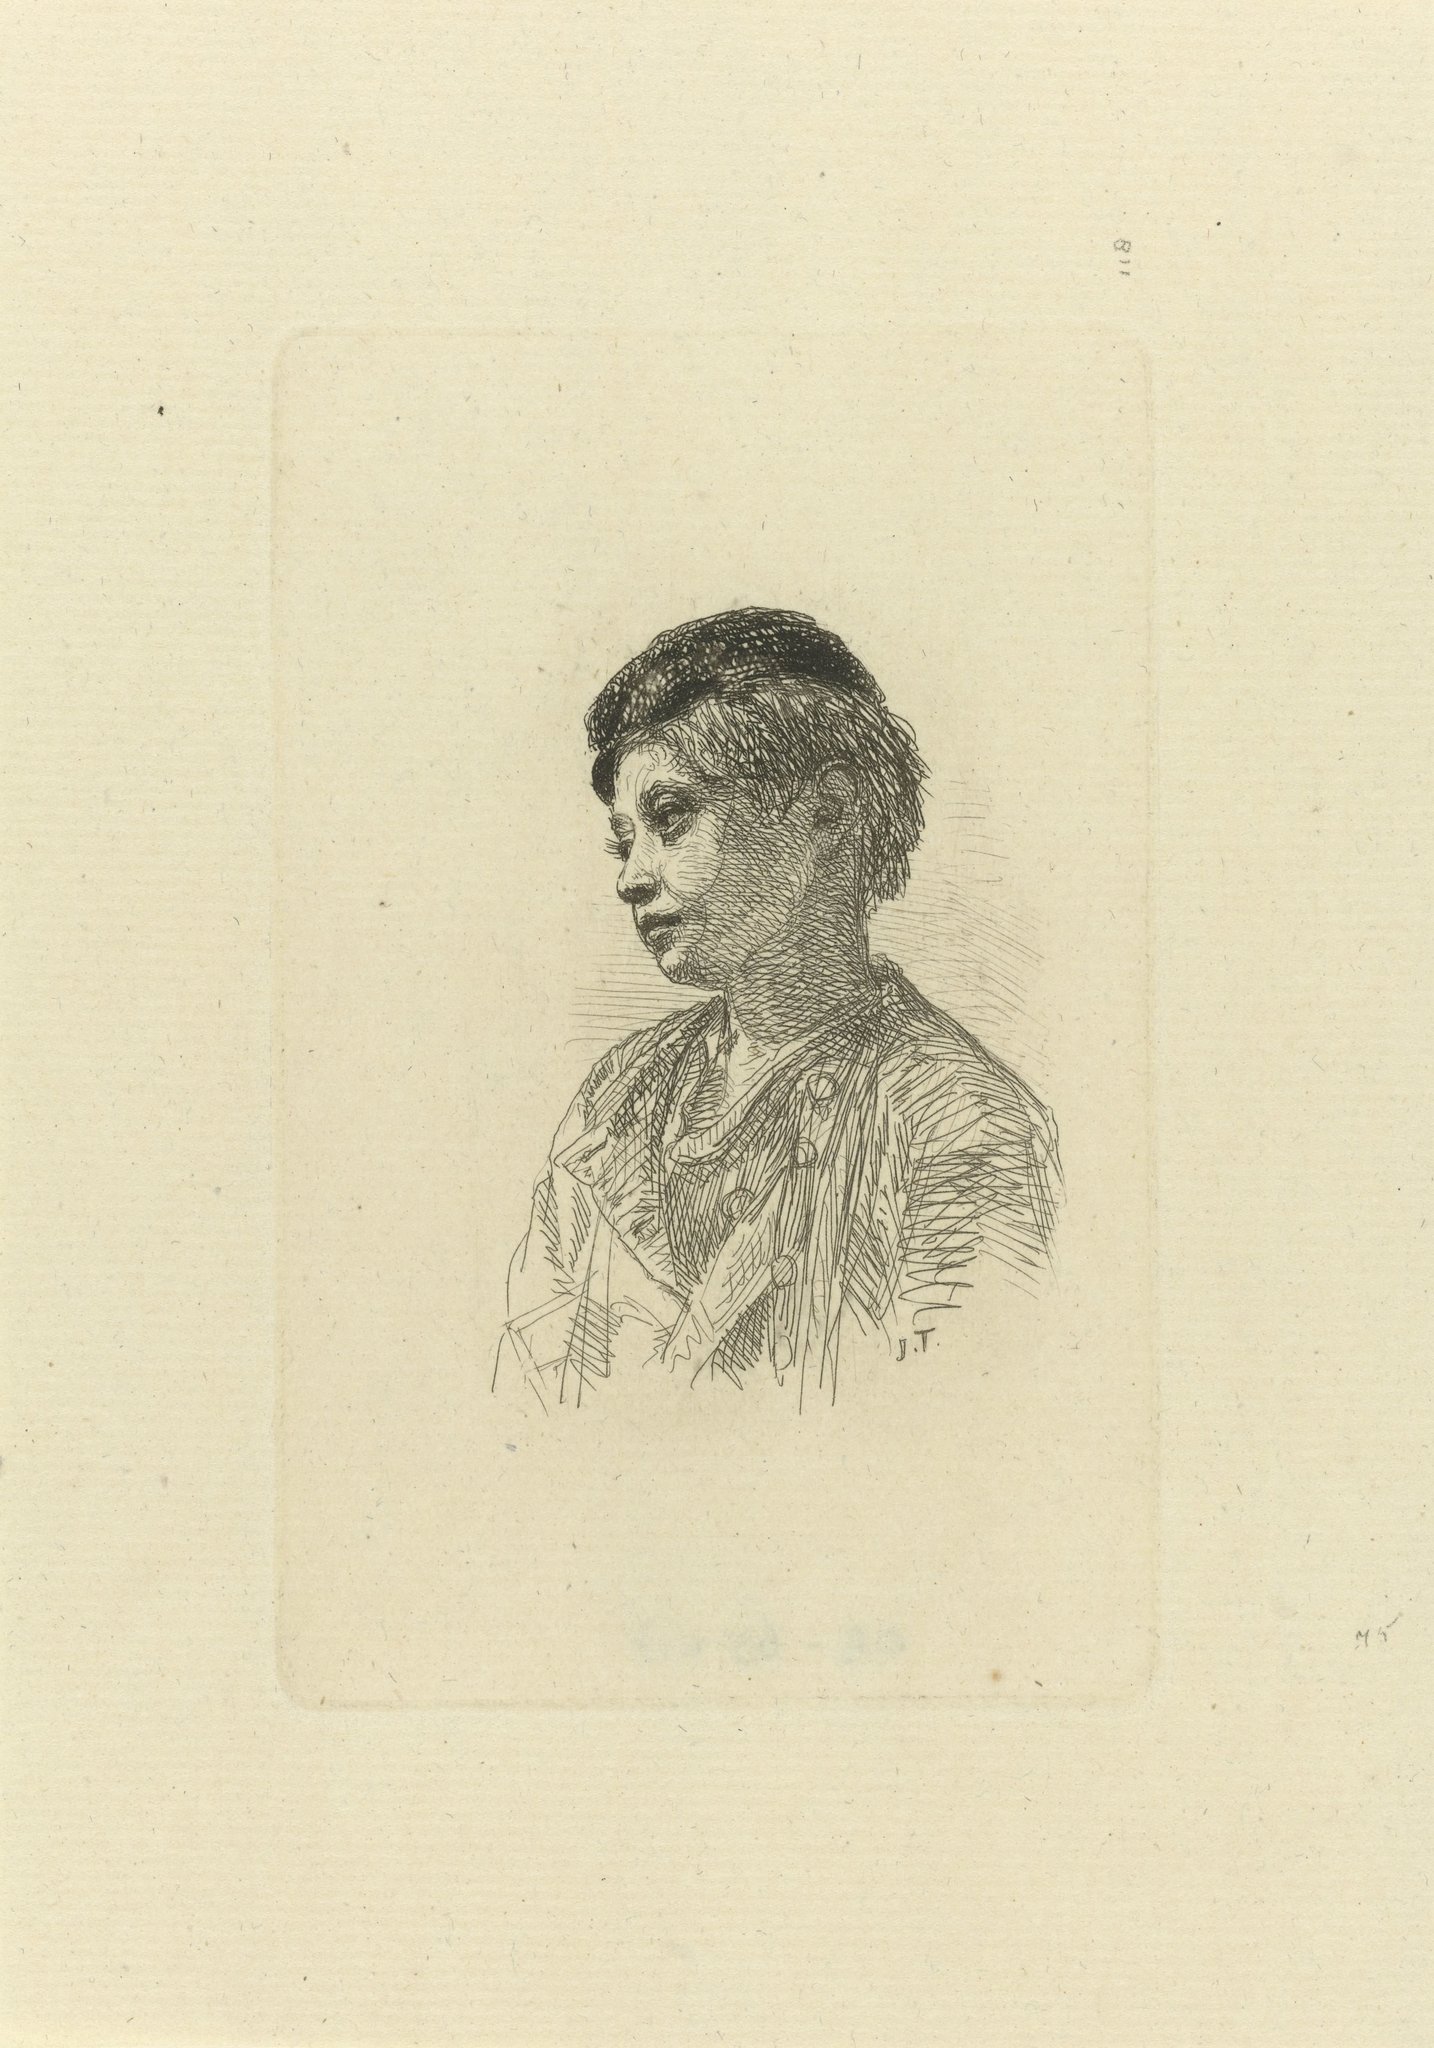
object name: print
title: Buste van een jongen met muts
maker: jacob taanman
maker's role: draughtsman, print maker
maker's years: 1836-1923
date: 1846-1877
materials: paper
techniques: etching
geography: amsterdam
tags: boy (child between toddler and youth)